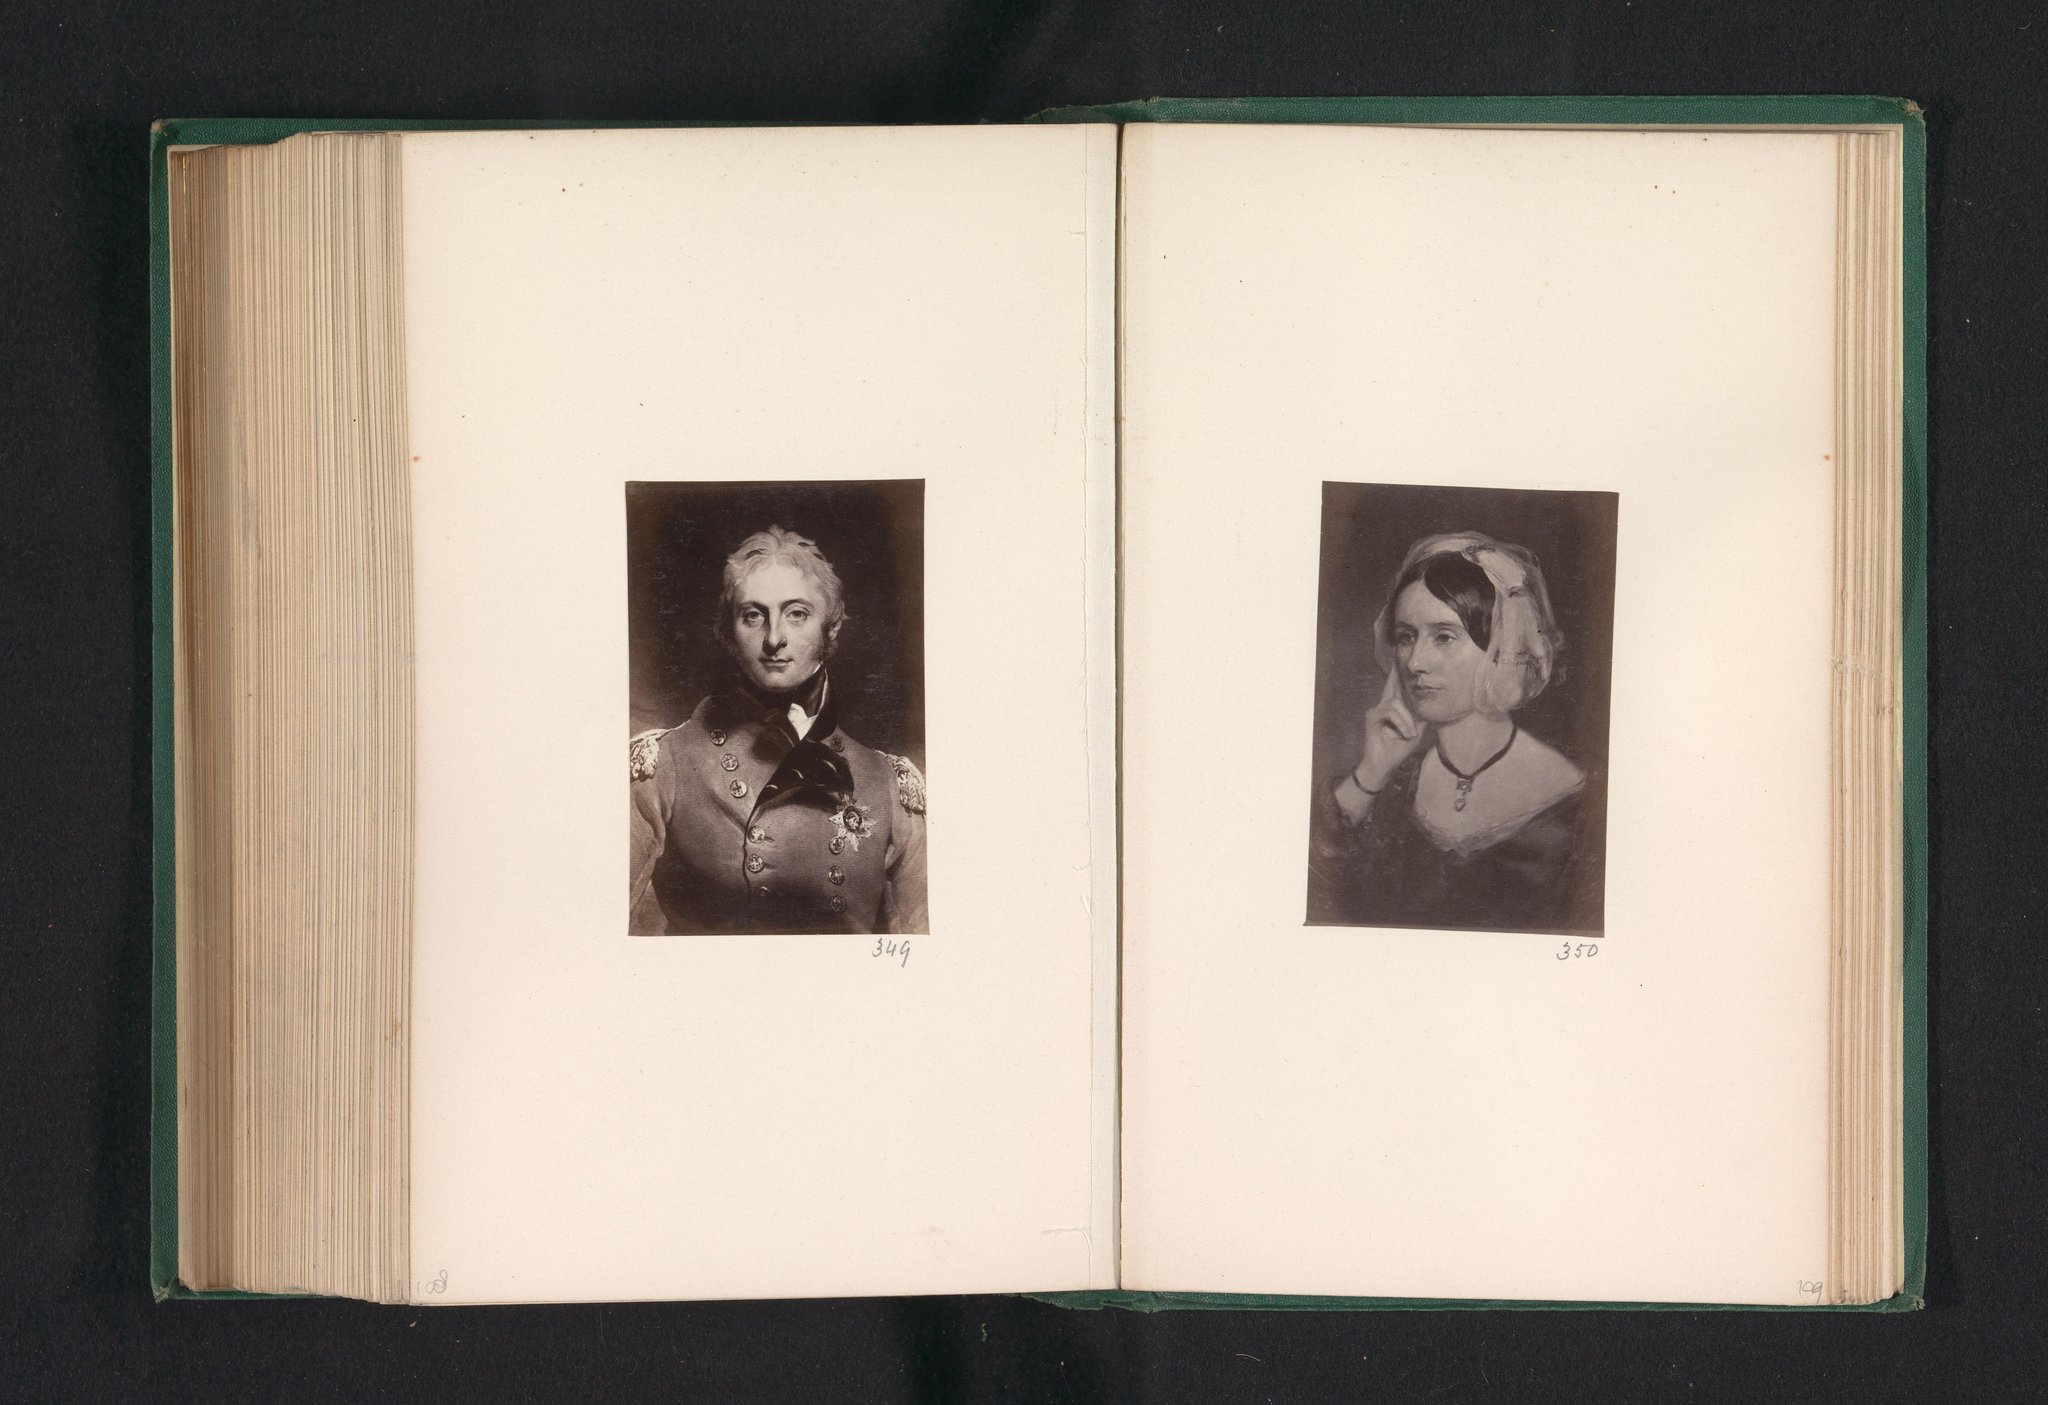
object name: page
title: Fotoreproductie van een schilderij, voorstellende een portret van Matilda Bruce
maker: thomas annan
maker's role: fotograaf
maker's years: 1829-1887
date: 1863-1868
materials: photographic support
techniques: albumen print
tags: historical persons (portraits and scenes from the life) - bb - woman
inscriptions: number: ‘350’